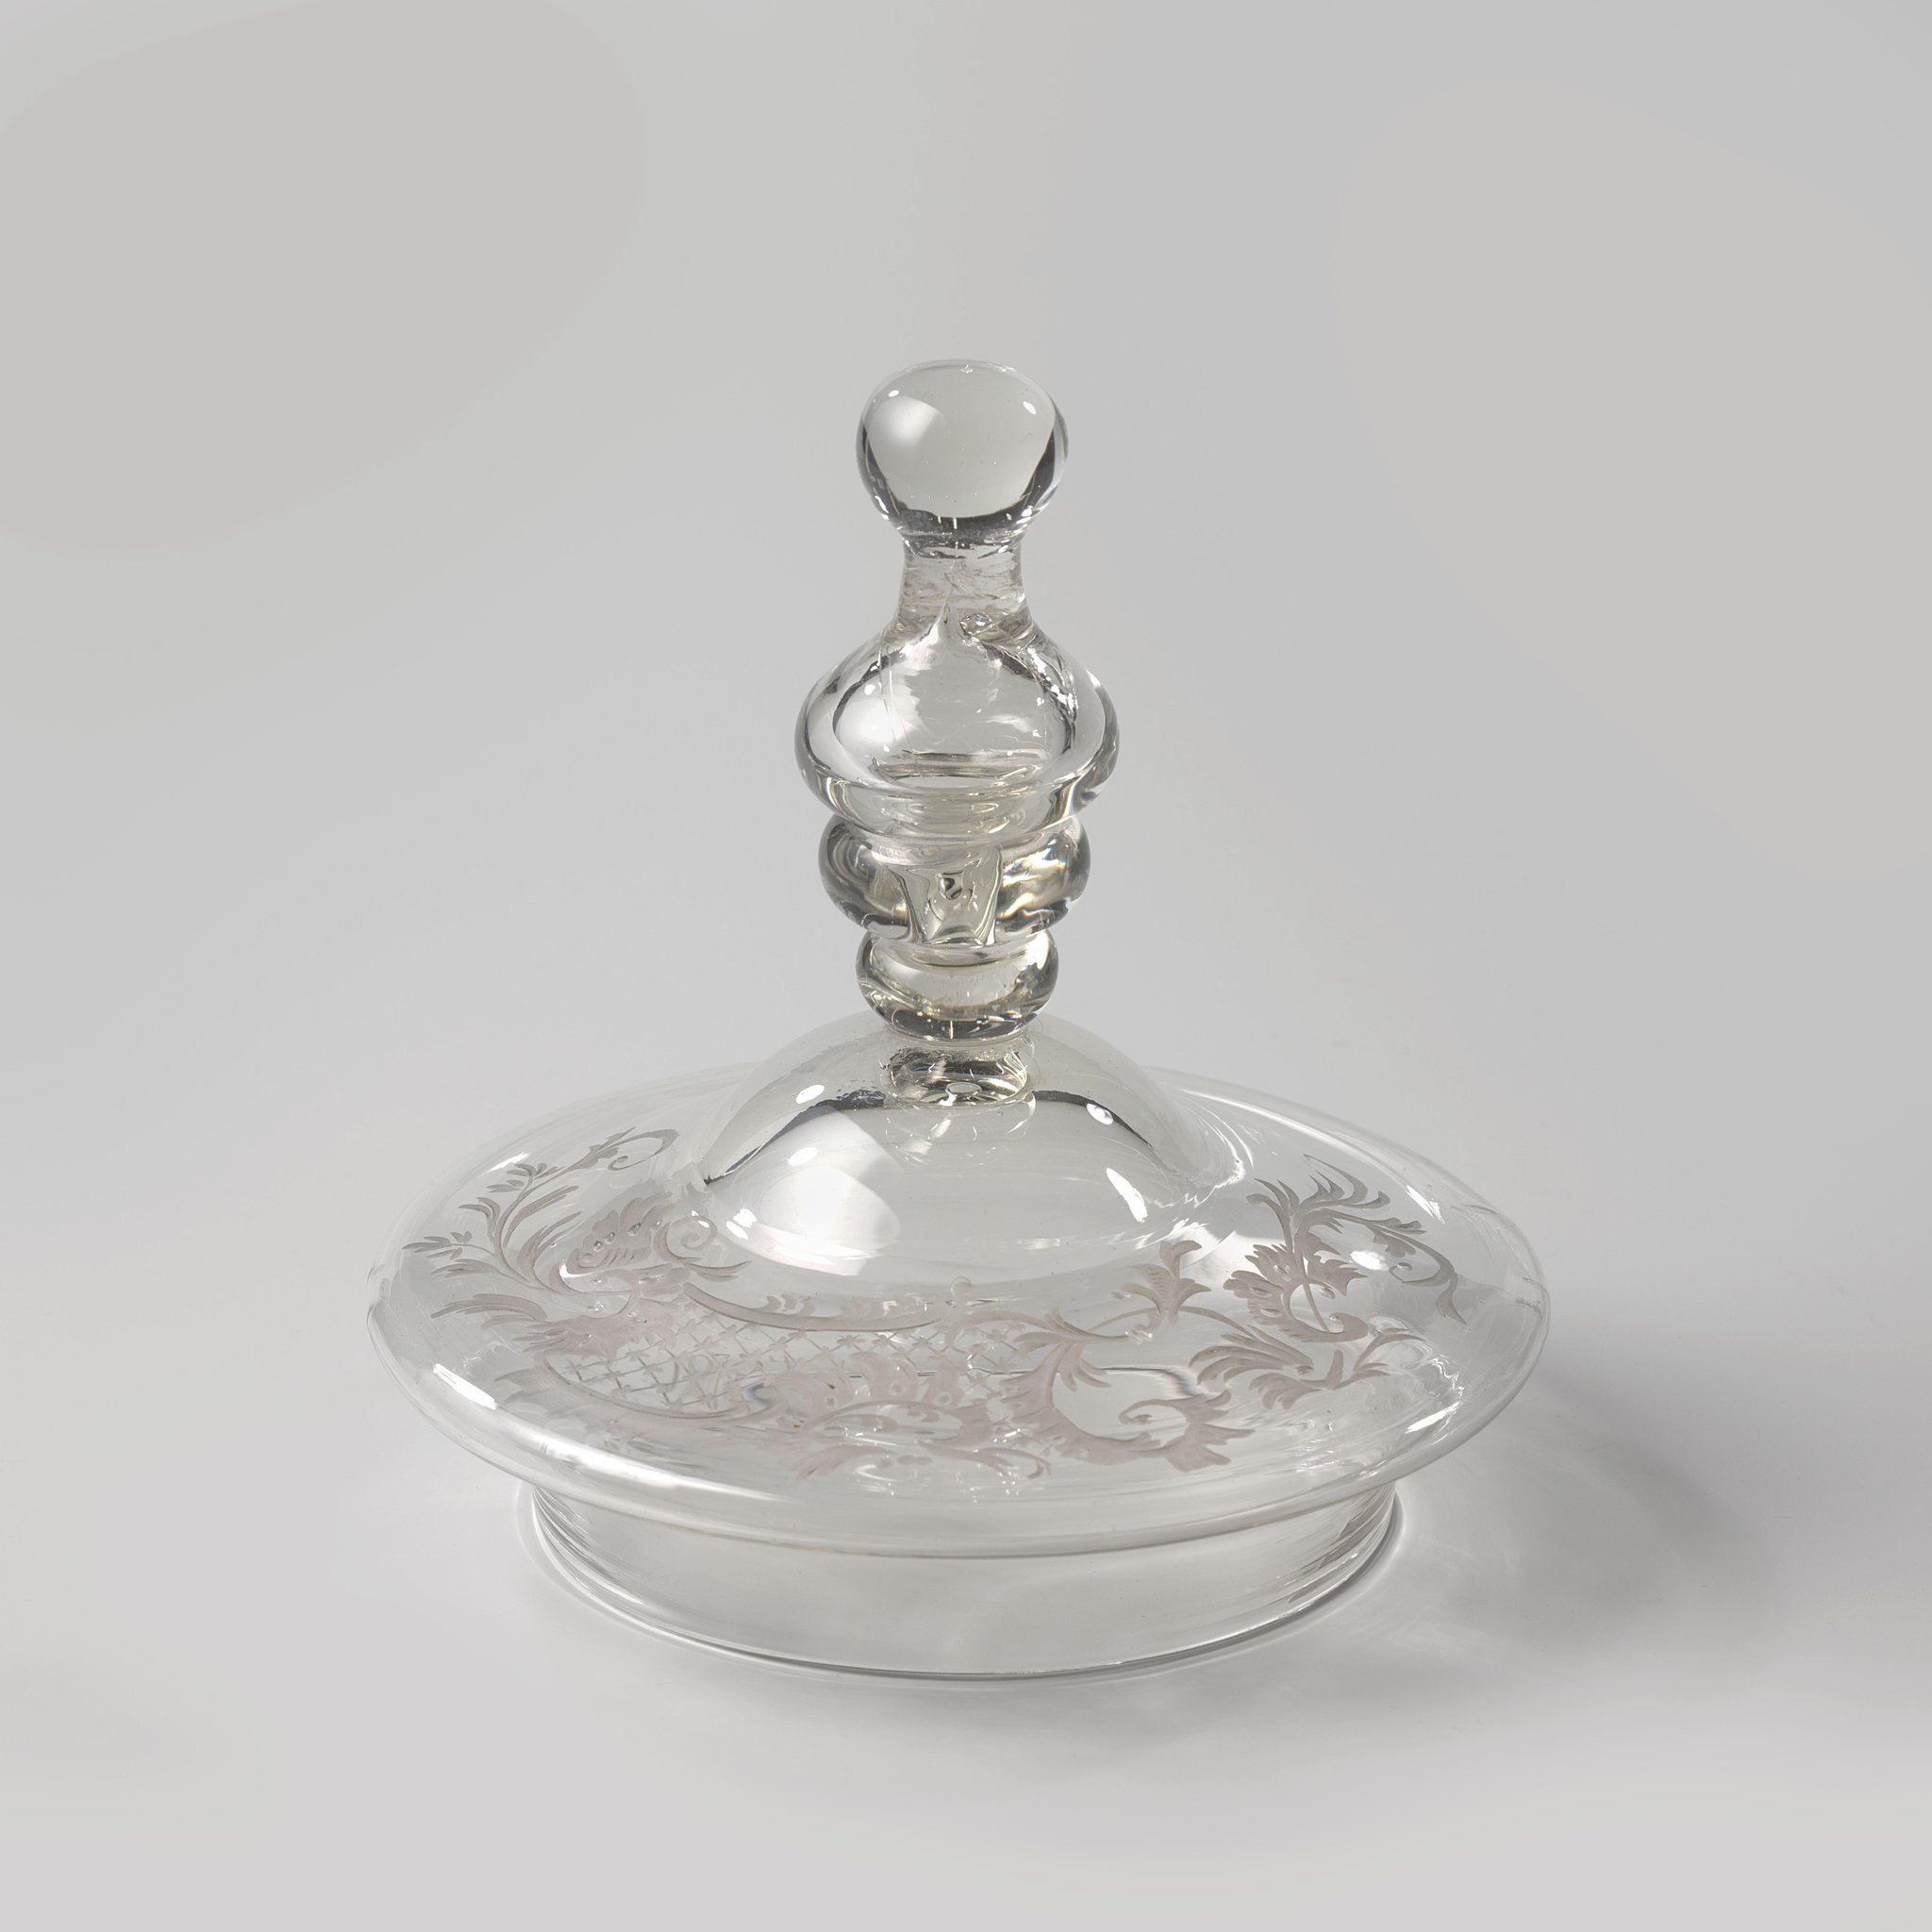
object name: lid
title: Deksel van een grote bokaal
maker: Anonymous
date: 1750-1760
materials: glass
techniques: glassblowing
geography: germany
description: Gewelfde deksel met koepelvormige verhoging, bekroond met gelede dekselknop met een luchtbel, bestaande uit drie knopen en een massieve, bolvormige uiteinde. Op de deksel rondlopend een gegraveerd bladornament.